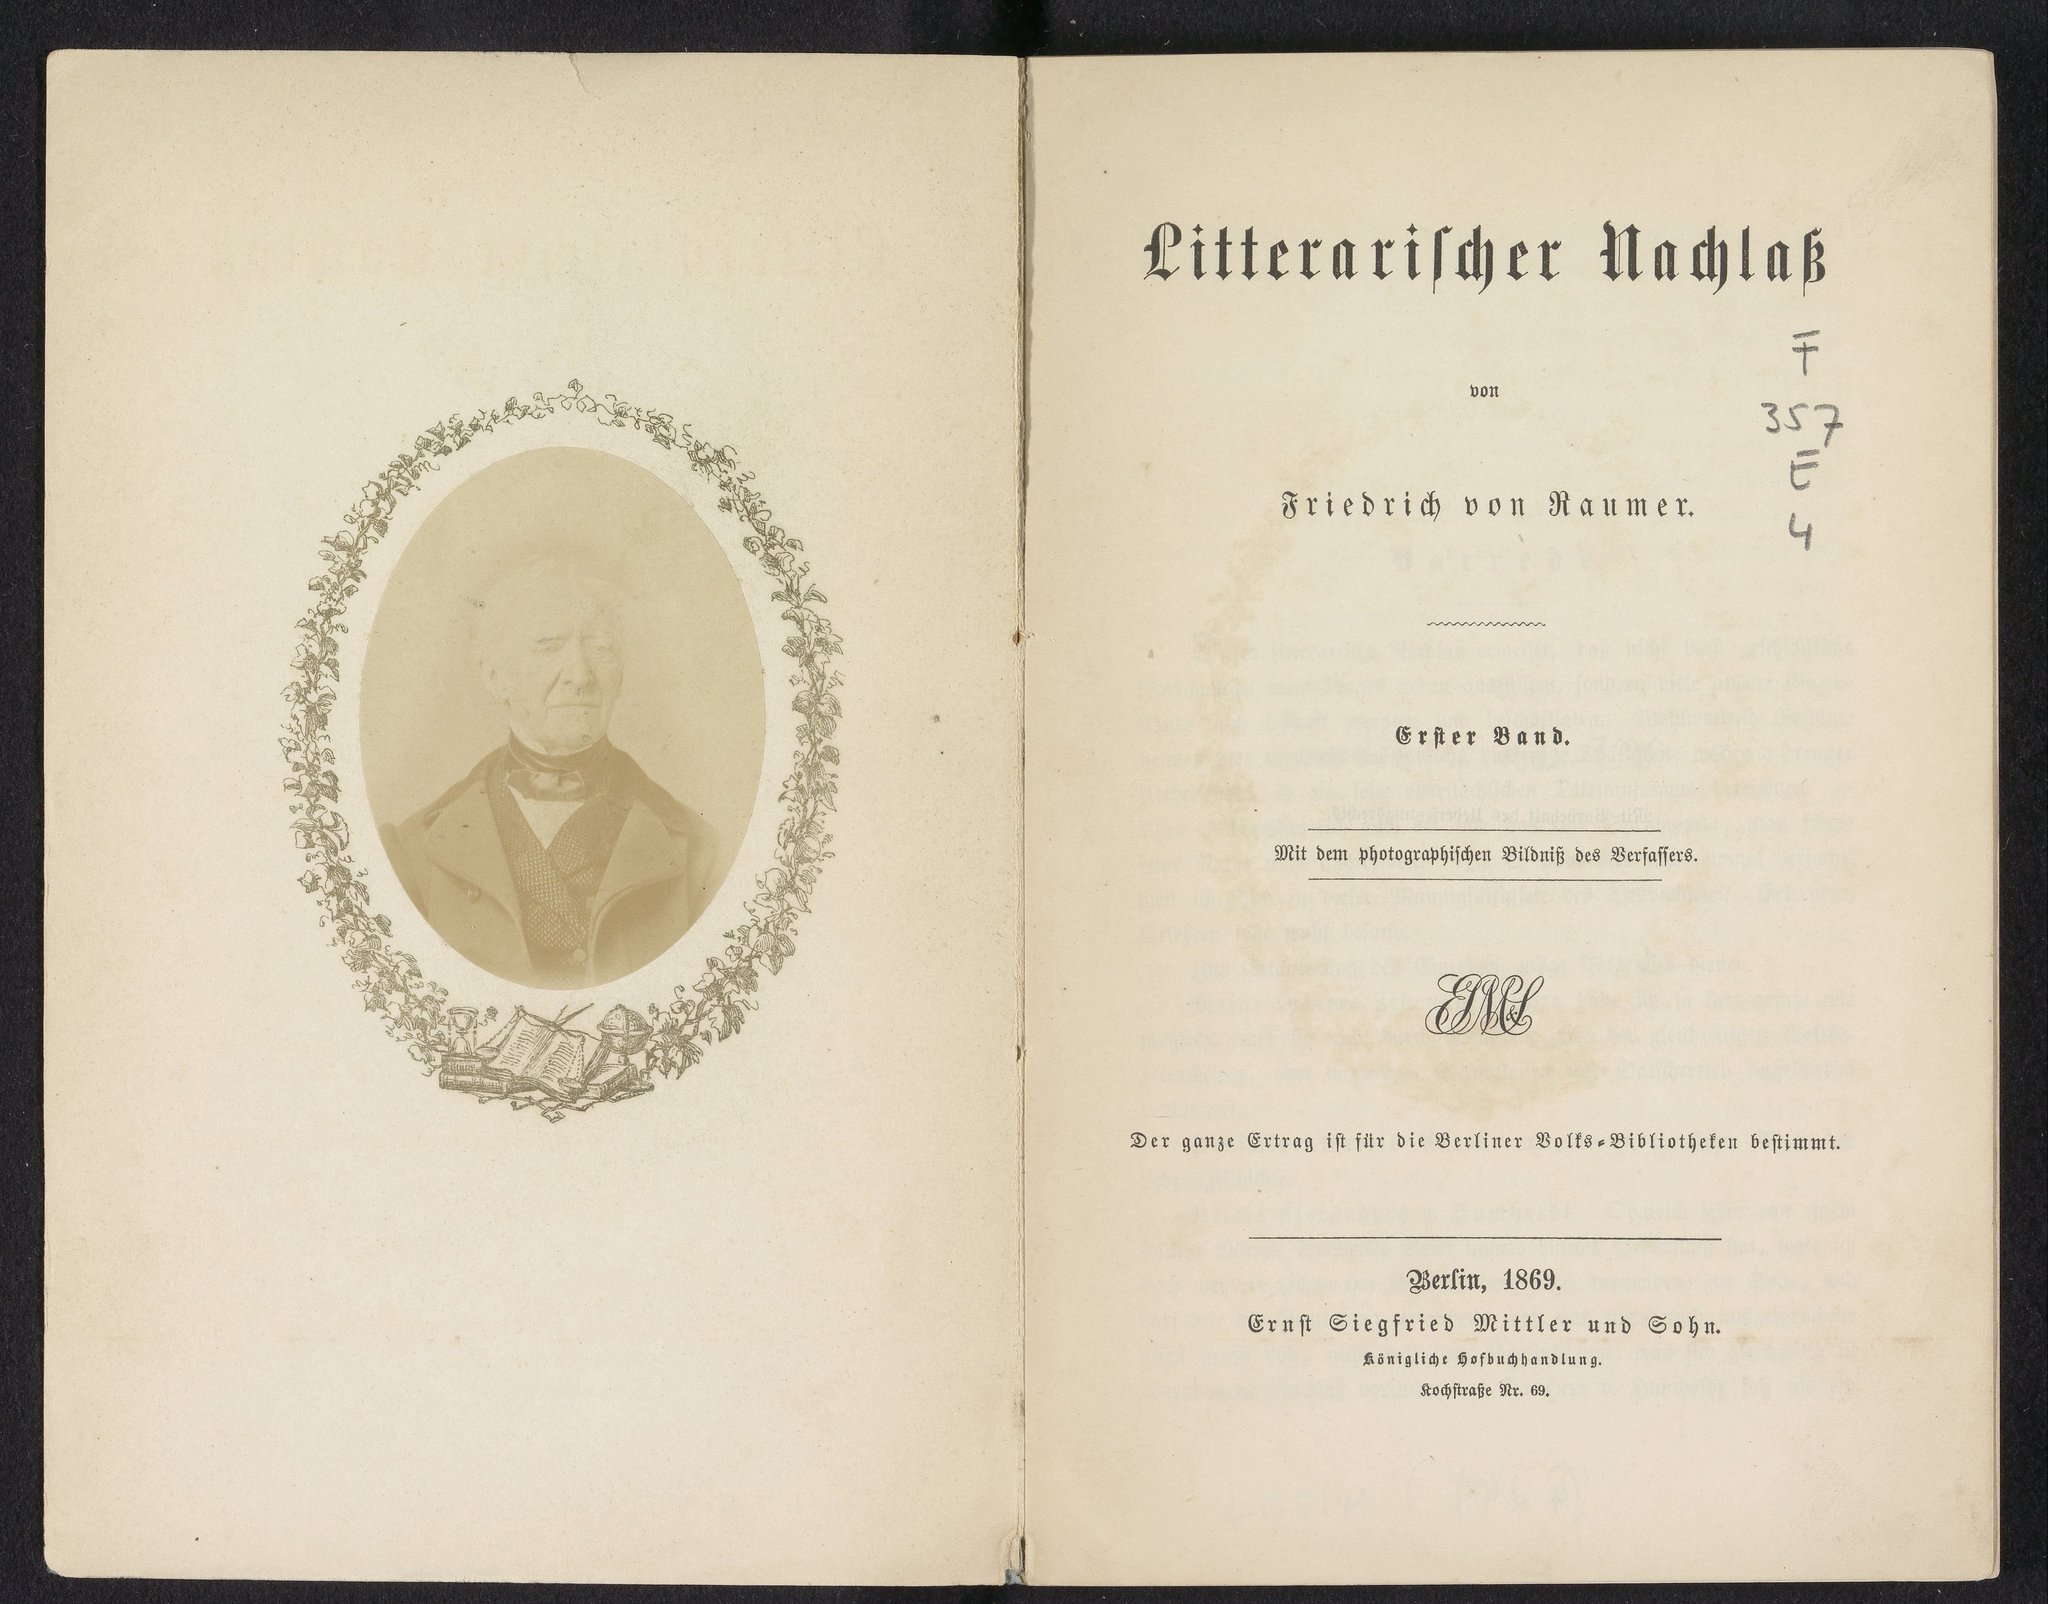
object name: photograph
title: Portret van Friedrich Ludwig Georg von Raumer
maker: Anonymous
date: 1859-1869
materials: photographic support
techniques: albumen print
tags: berlin, politician, friedrich von raumer, portrait of a writer